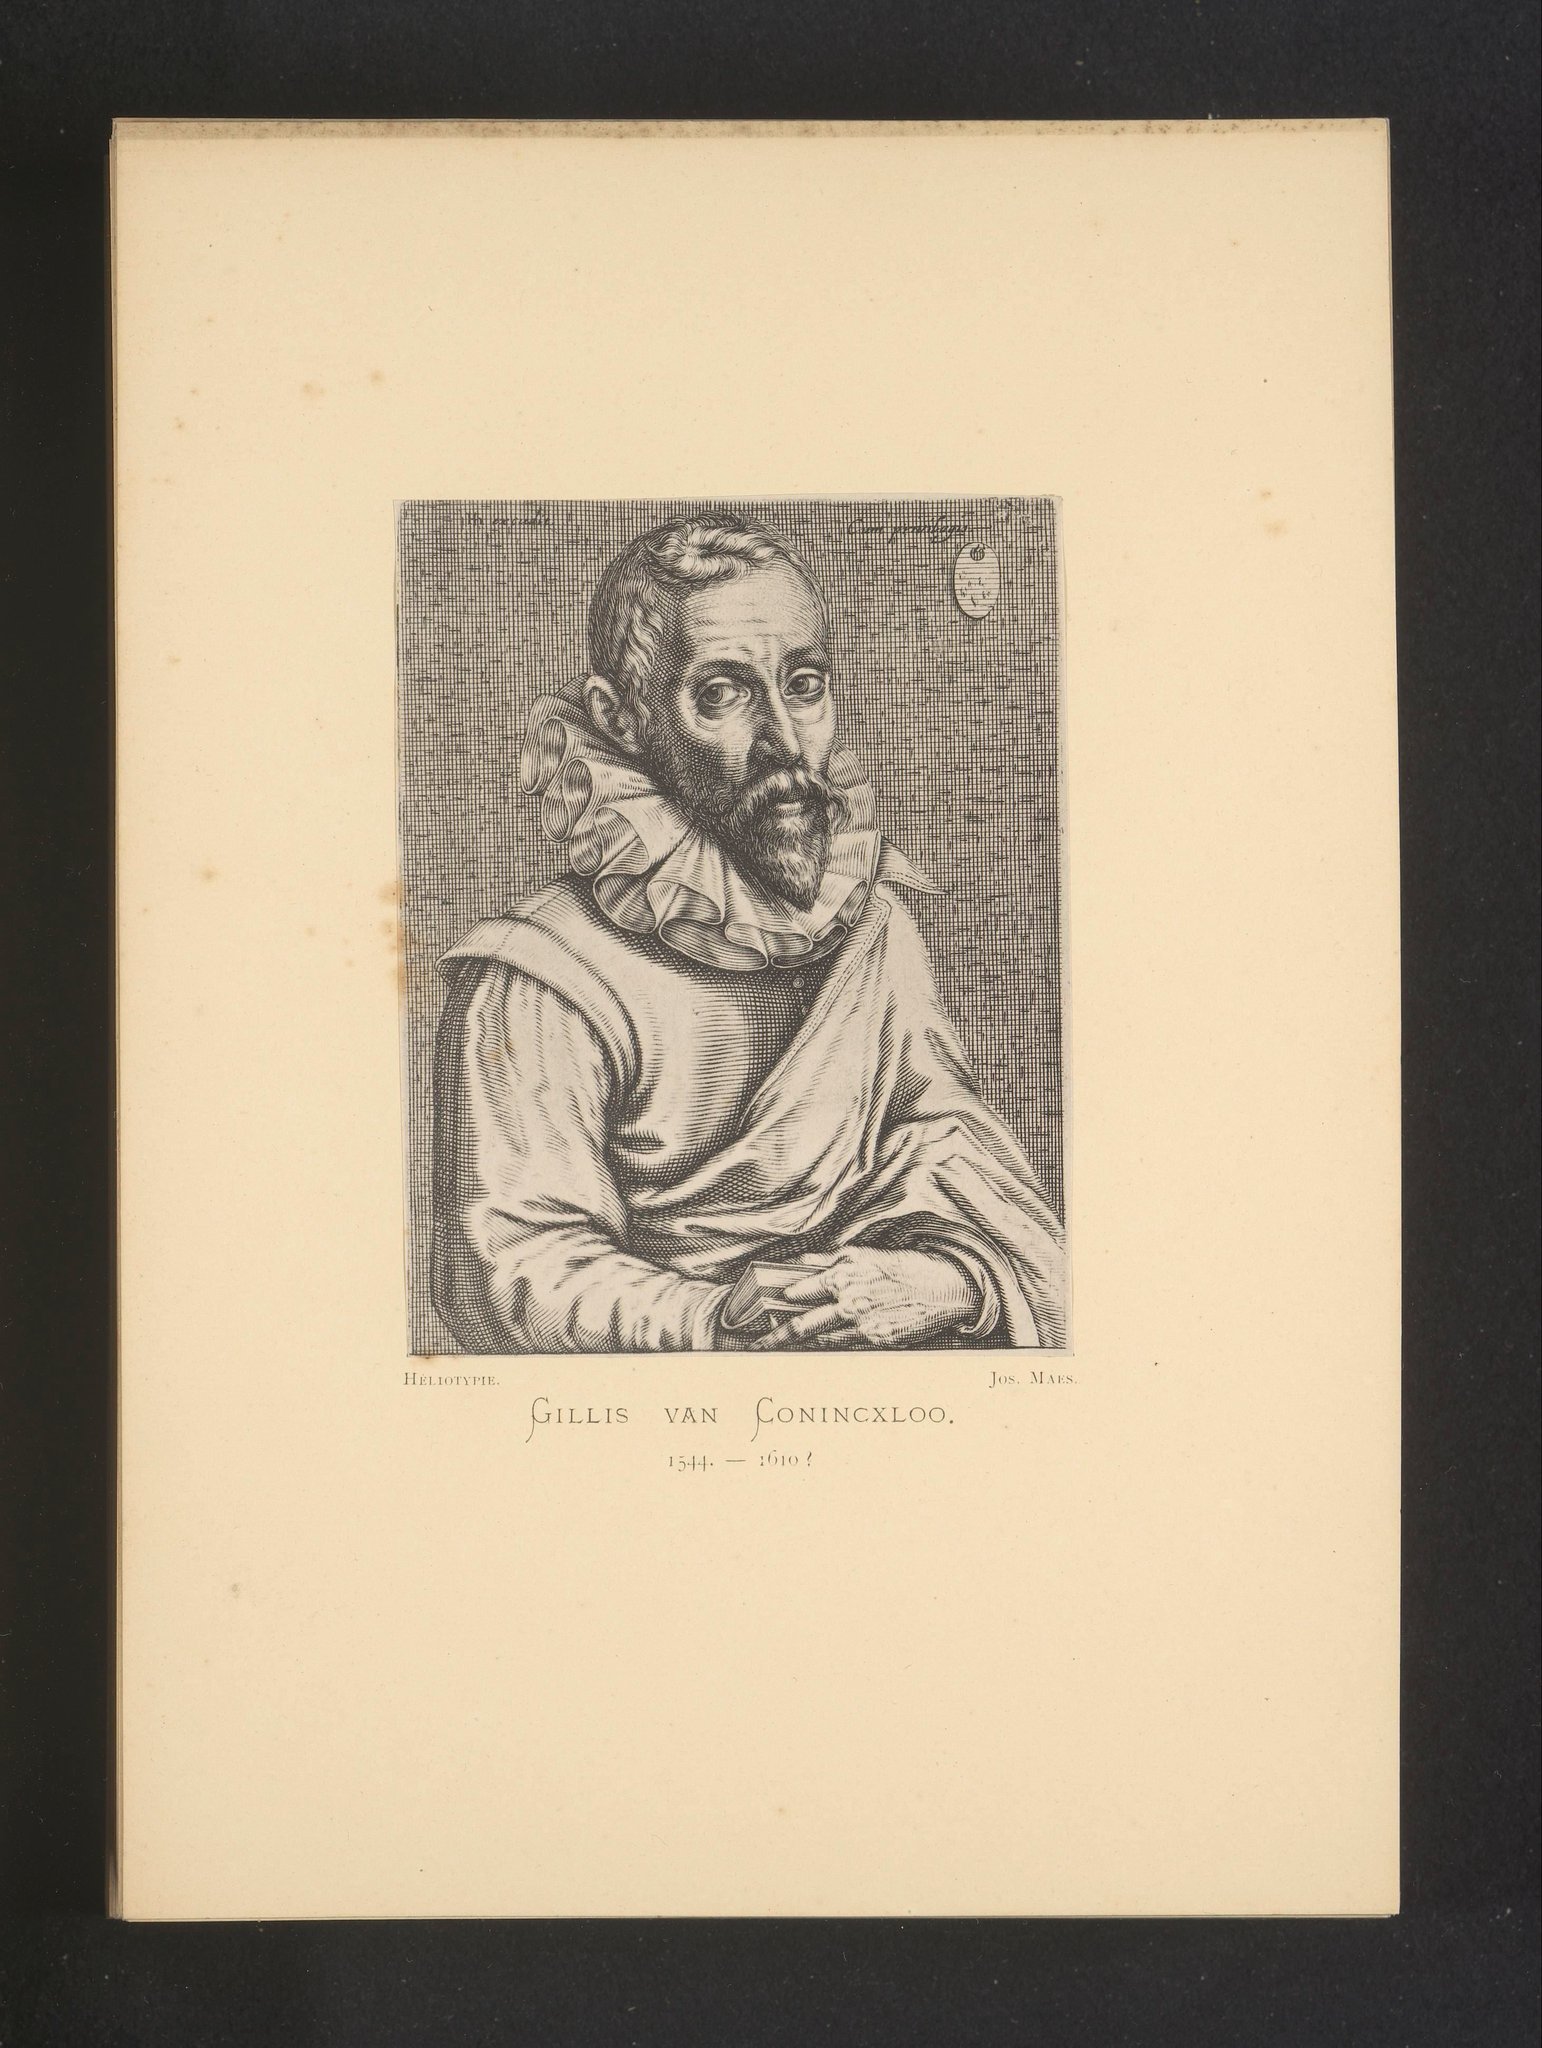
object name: photomechanical print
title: Gillis van Conincxloo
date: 1872-1877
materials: cardboard, paper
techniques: photograph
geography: antwerp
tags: antwerp, amsterdam, painter, draughtsman, gilles van coninxloo (ii), historical persons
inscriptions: inscription: ‘1544. - 1610?’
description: Deze prent maakt deel uit van een omslag met 150 prenten en een katern met een lijst van afbeeldingen.